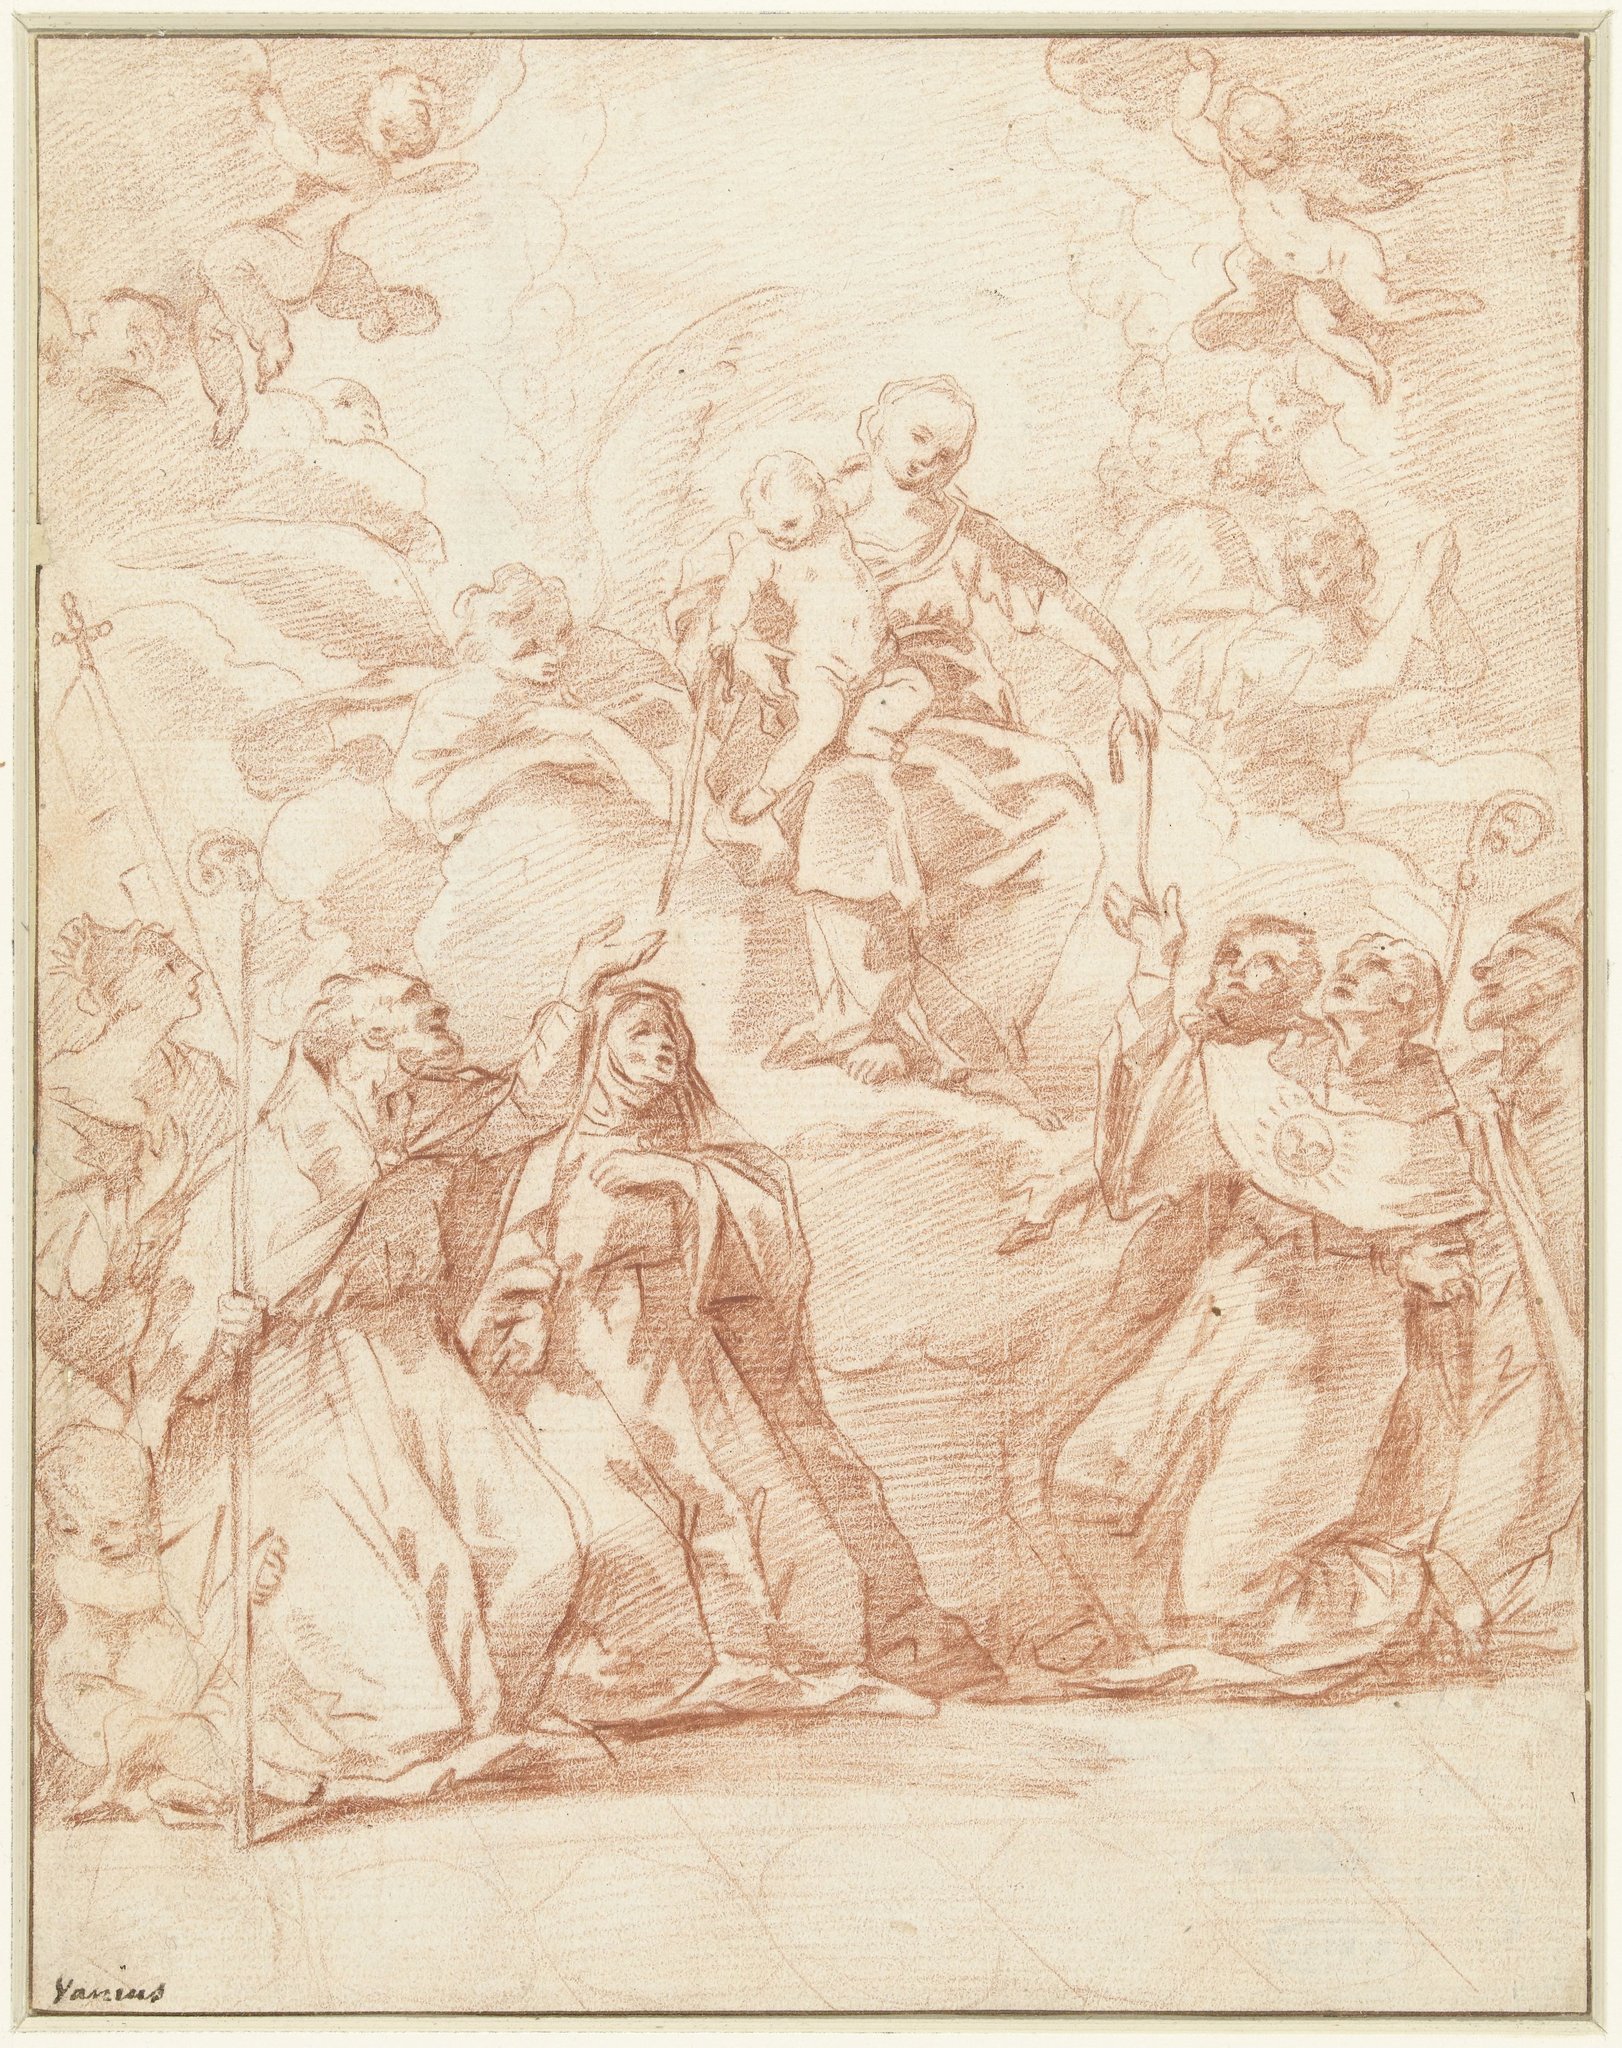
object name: drawing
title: Madonna en het kind reiken scapulieren uit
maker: francesco vanni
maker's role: draughtsman, print maker, publisher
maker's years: 1563-1610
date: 1573-1610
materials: chalk, paper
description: De Madonna en het kind, gezeten op wolken en door engelen omgeven, reiken scapulieren uit aan zes geknielde heiligen.